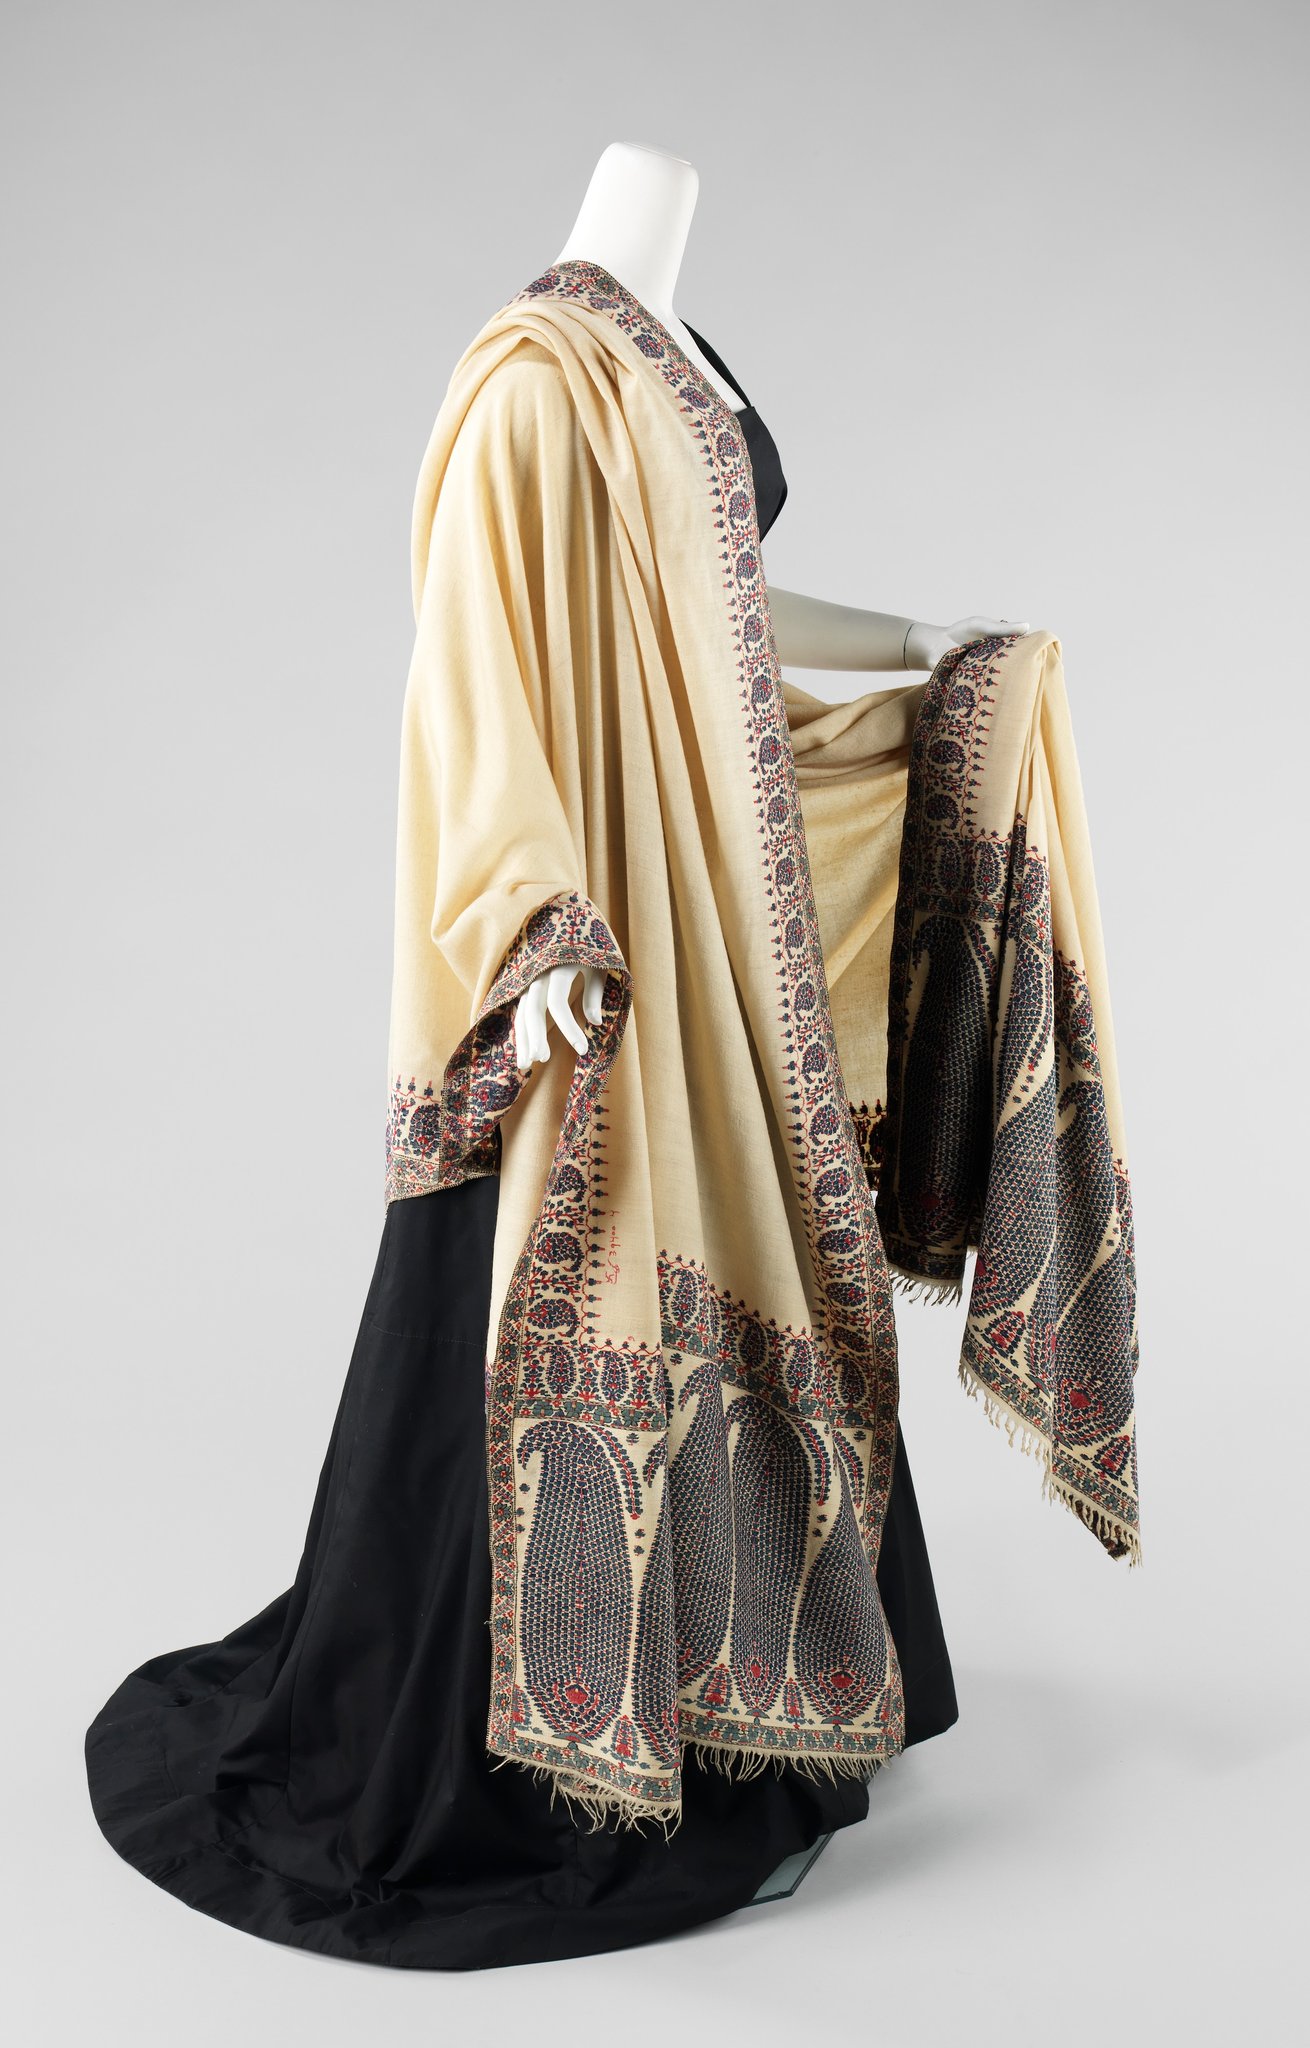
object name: shawl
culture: indian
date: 1851-1875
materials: silk, wool